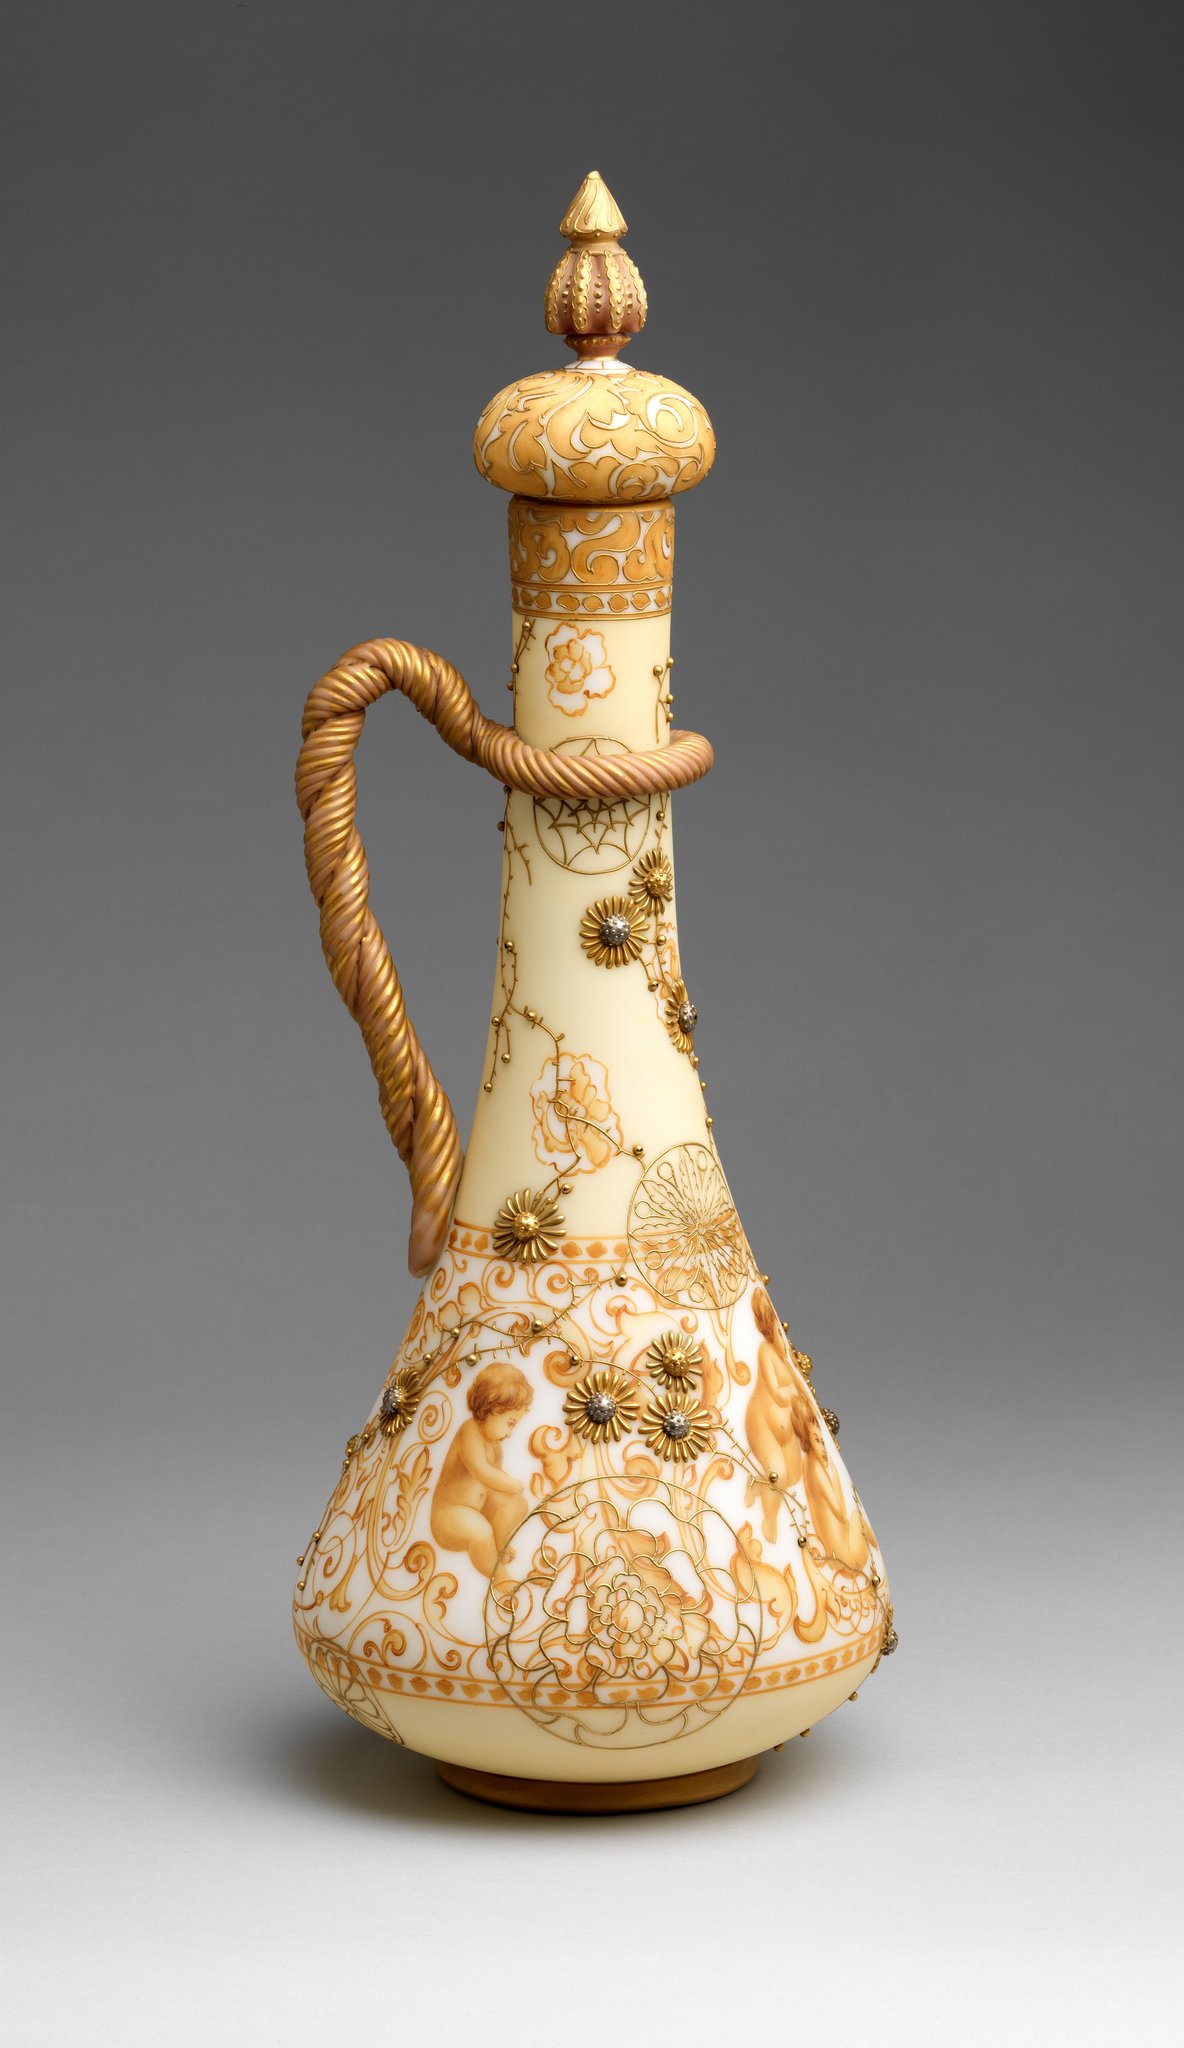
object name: ewer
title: Crown Milano Covered Ewer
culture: american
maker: mount washington glass company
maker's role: maker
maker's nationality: american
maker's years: 1837-1958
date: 1892-1893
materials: glass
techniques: glassblowing, gilding, painting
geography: united states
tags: infants,flowers